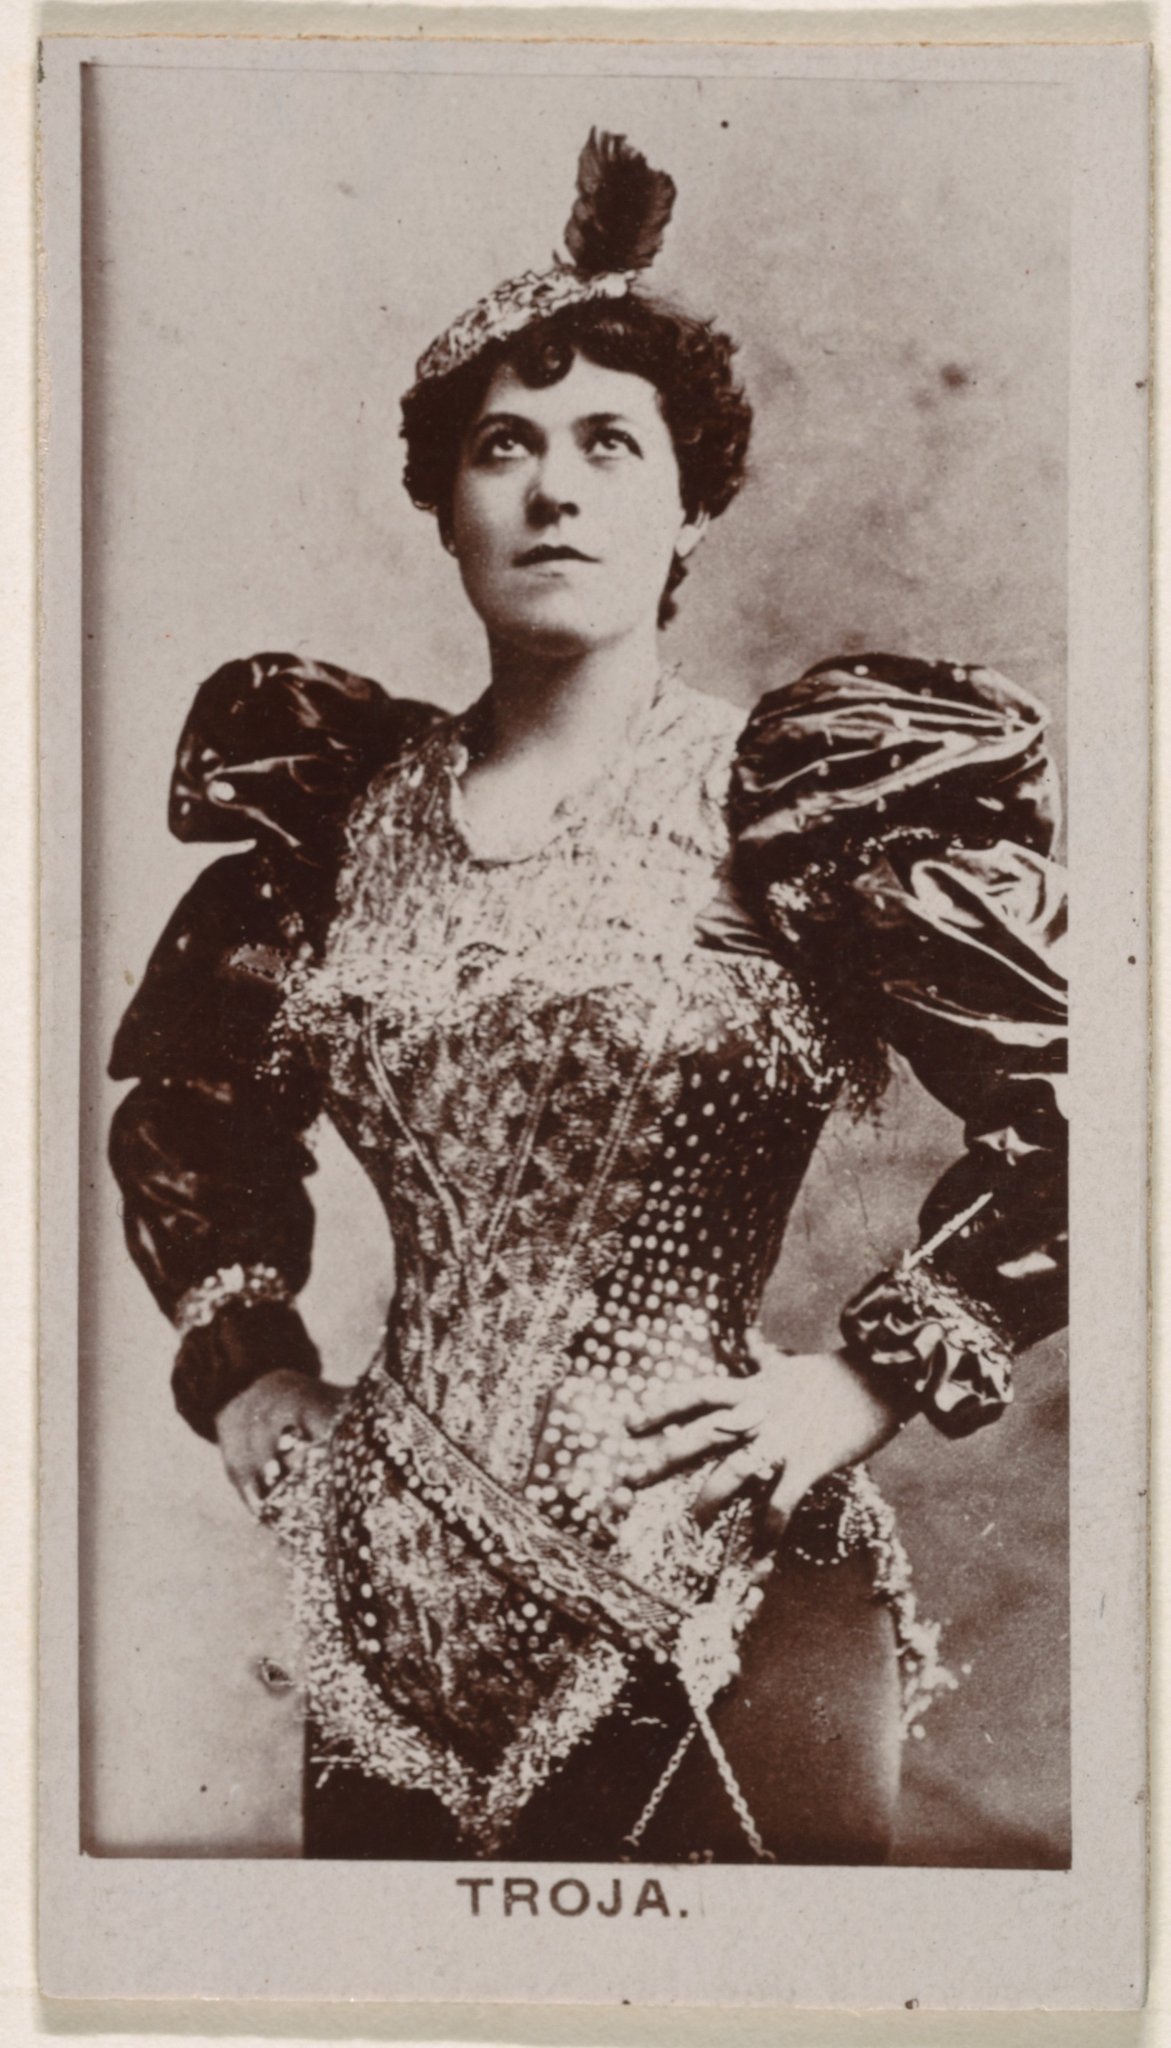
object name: photograph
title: Miss Troja, from the Actresses series (N245) issued by Kinney Brothers to promote Sweet Caporal Cigarettes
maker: kinney brothers tobacco company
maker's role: publisher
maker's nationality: american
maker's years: 1869-2011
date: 1890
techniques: albumen silver print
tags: portraits,women,actresses